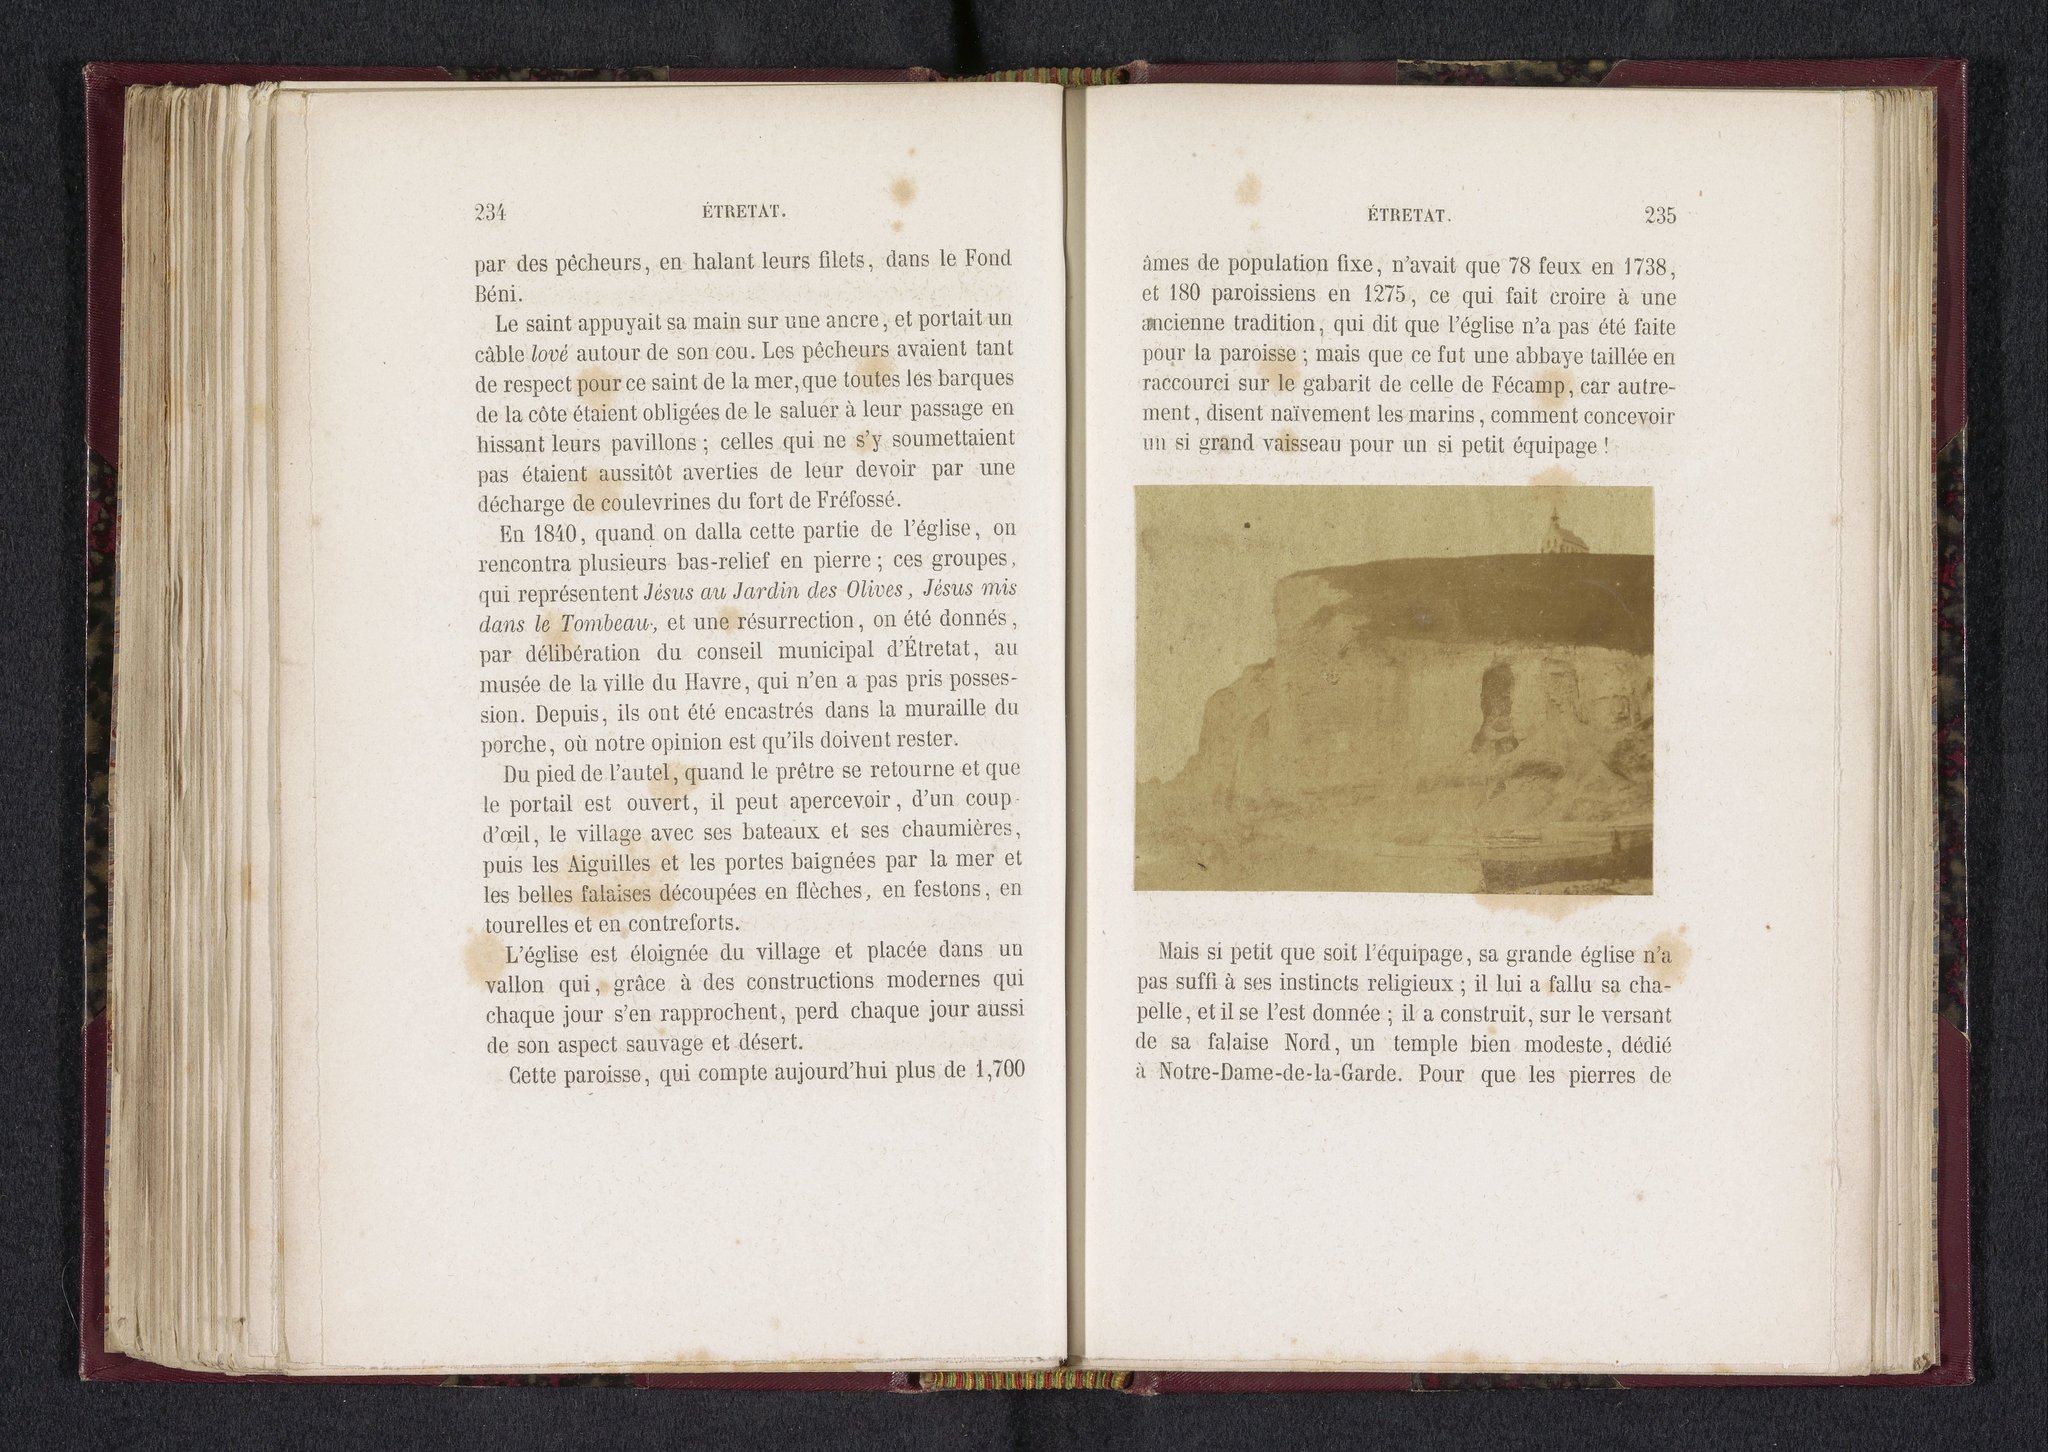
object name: page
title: Rotskust met daarop een kerk bij Étretat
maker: kaiser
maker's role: fotograaf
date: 1850-1860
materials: photographic support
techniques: albumen print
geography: etretat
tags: rocky coast